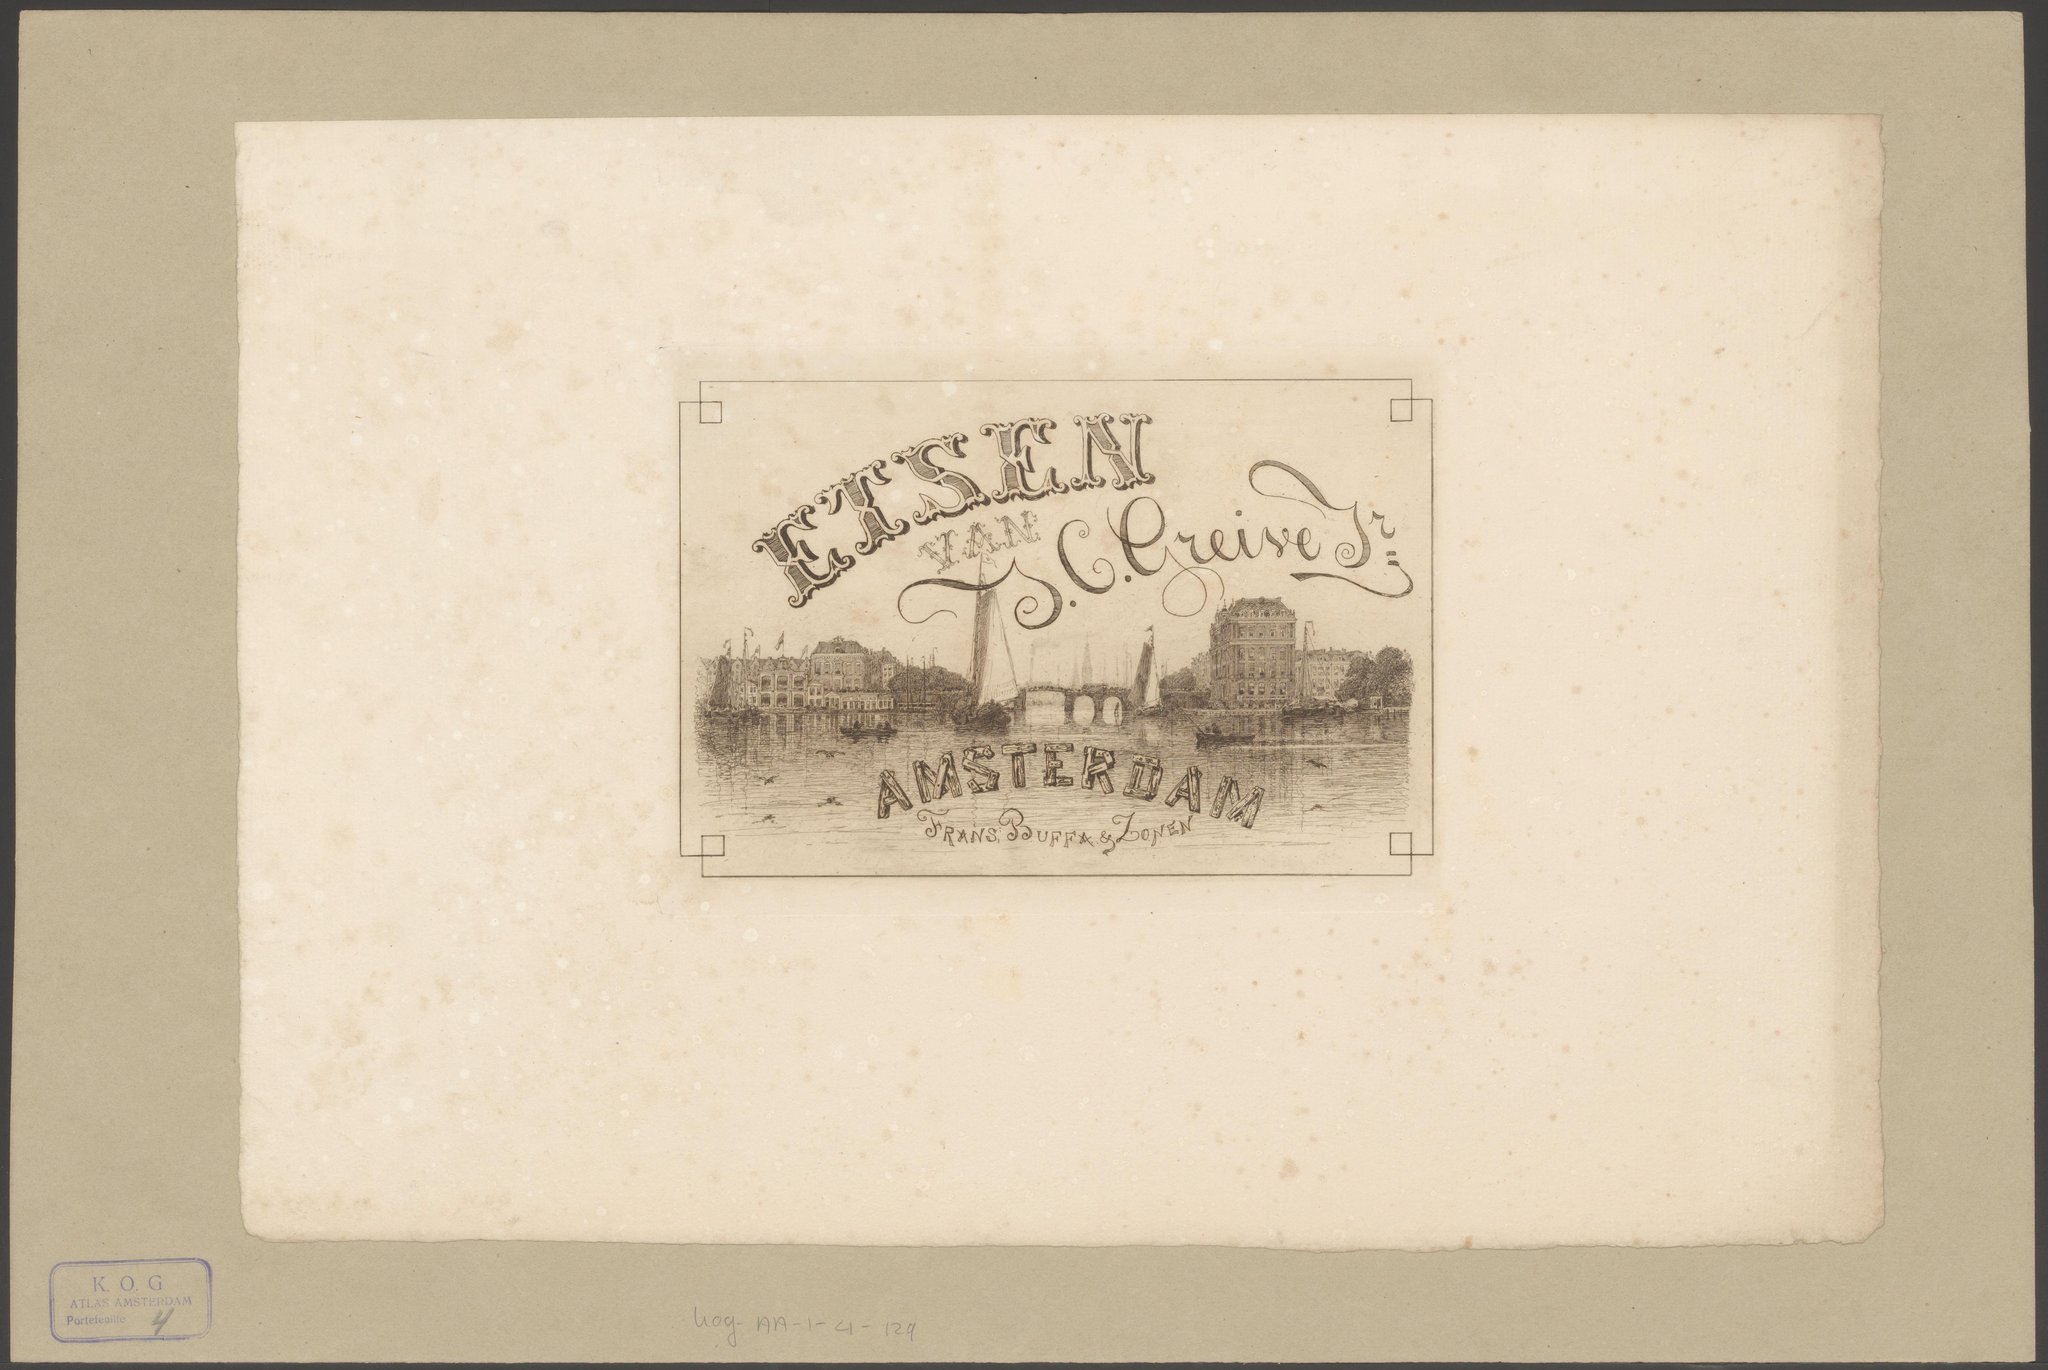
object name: titelprent, frontispice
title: Gezicht op de Hogesluis vanaf de Amstel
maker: johan conrad greive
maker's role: draughtsman, painter, print maker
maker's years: 1837-1891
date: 1847-1891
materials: paper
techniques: etching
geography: amsterdam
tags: sailing-ship, sailing-boat, city-view in general; 'veduta', river, bridge in city across river, canal, etc.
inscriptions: collector's mark: ‘4’ Lugt 1641b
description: Onderwerpsrubriek binnen de Atlas Amsterdam: Amstel van Hogesluis stroomopwaarts.